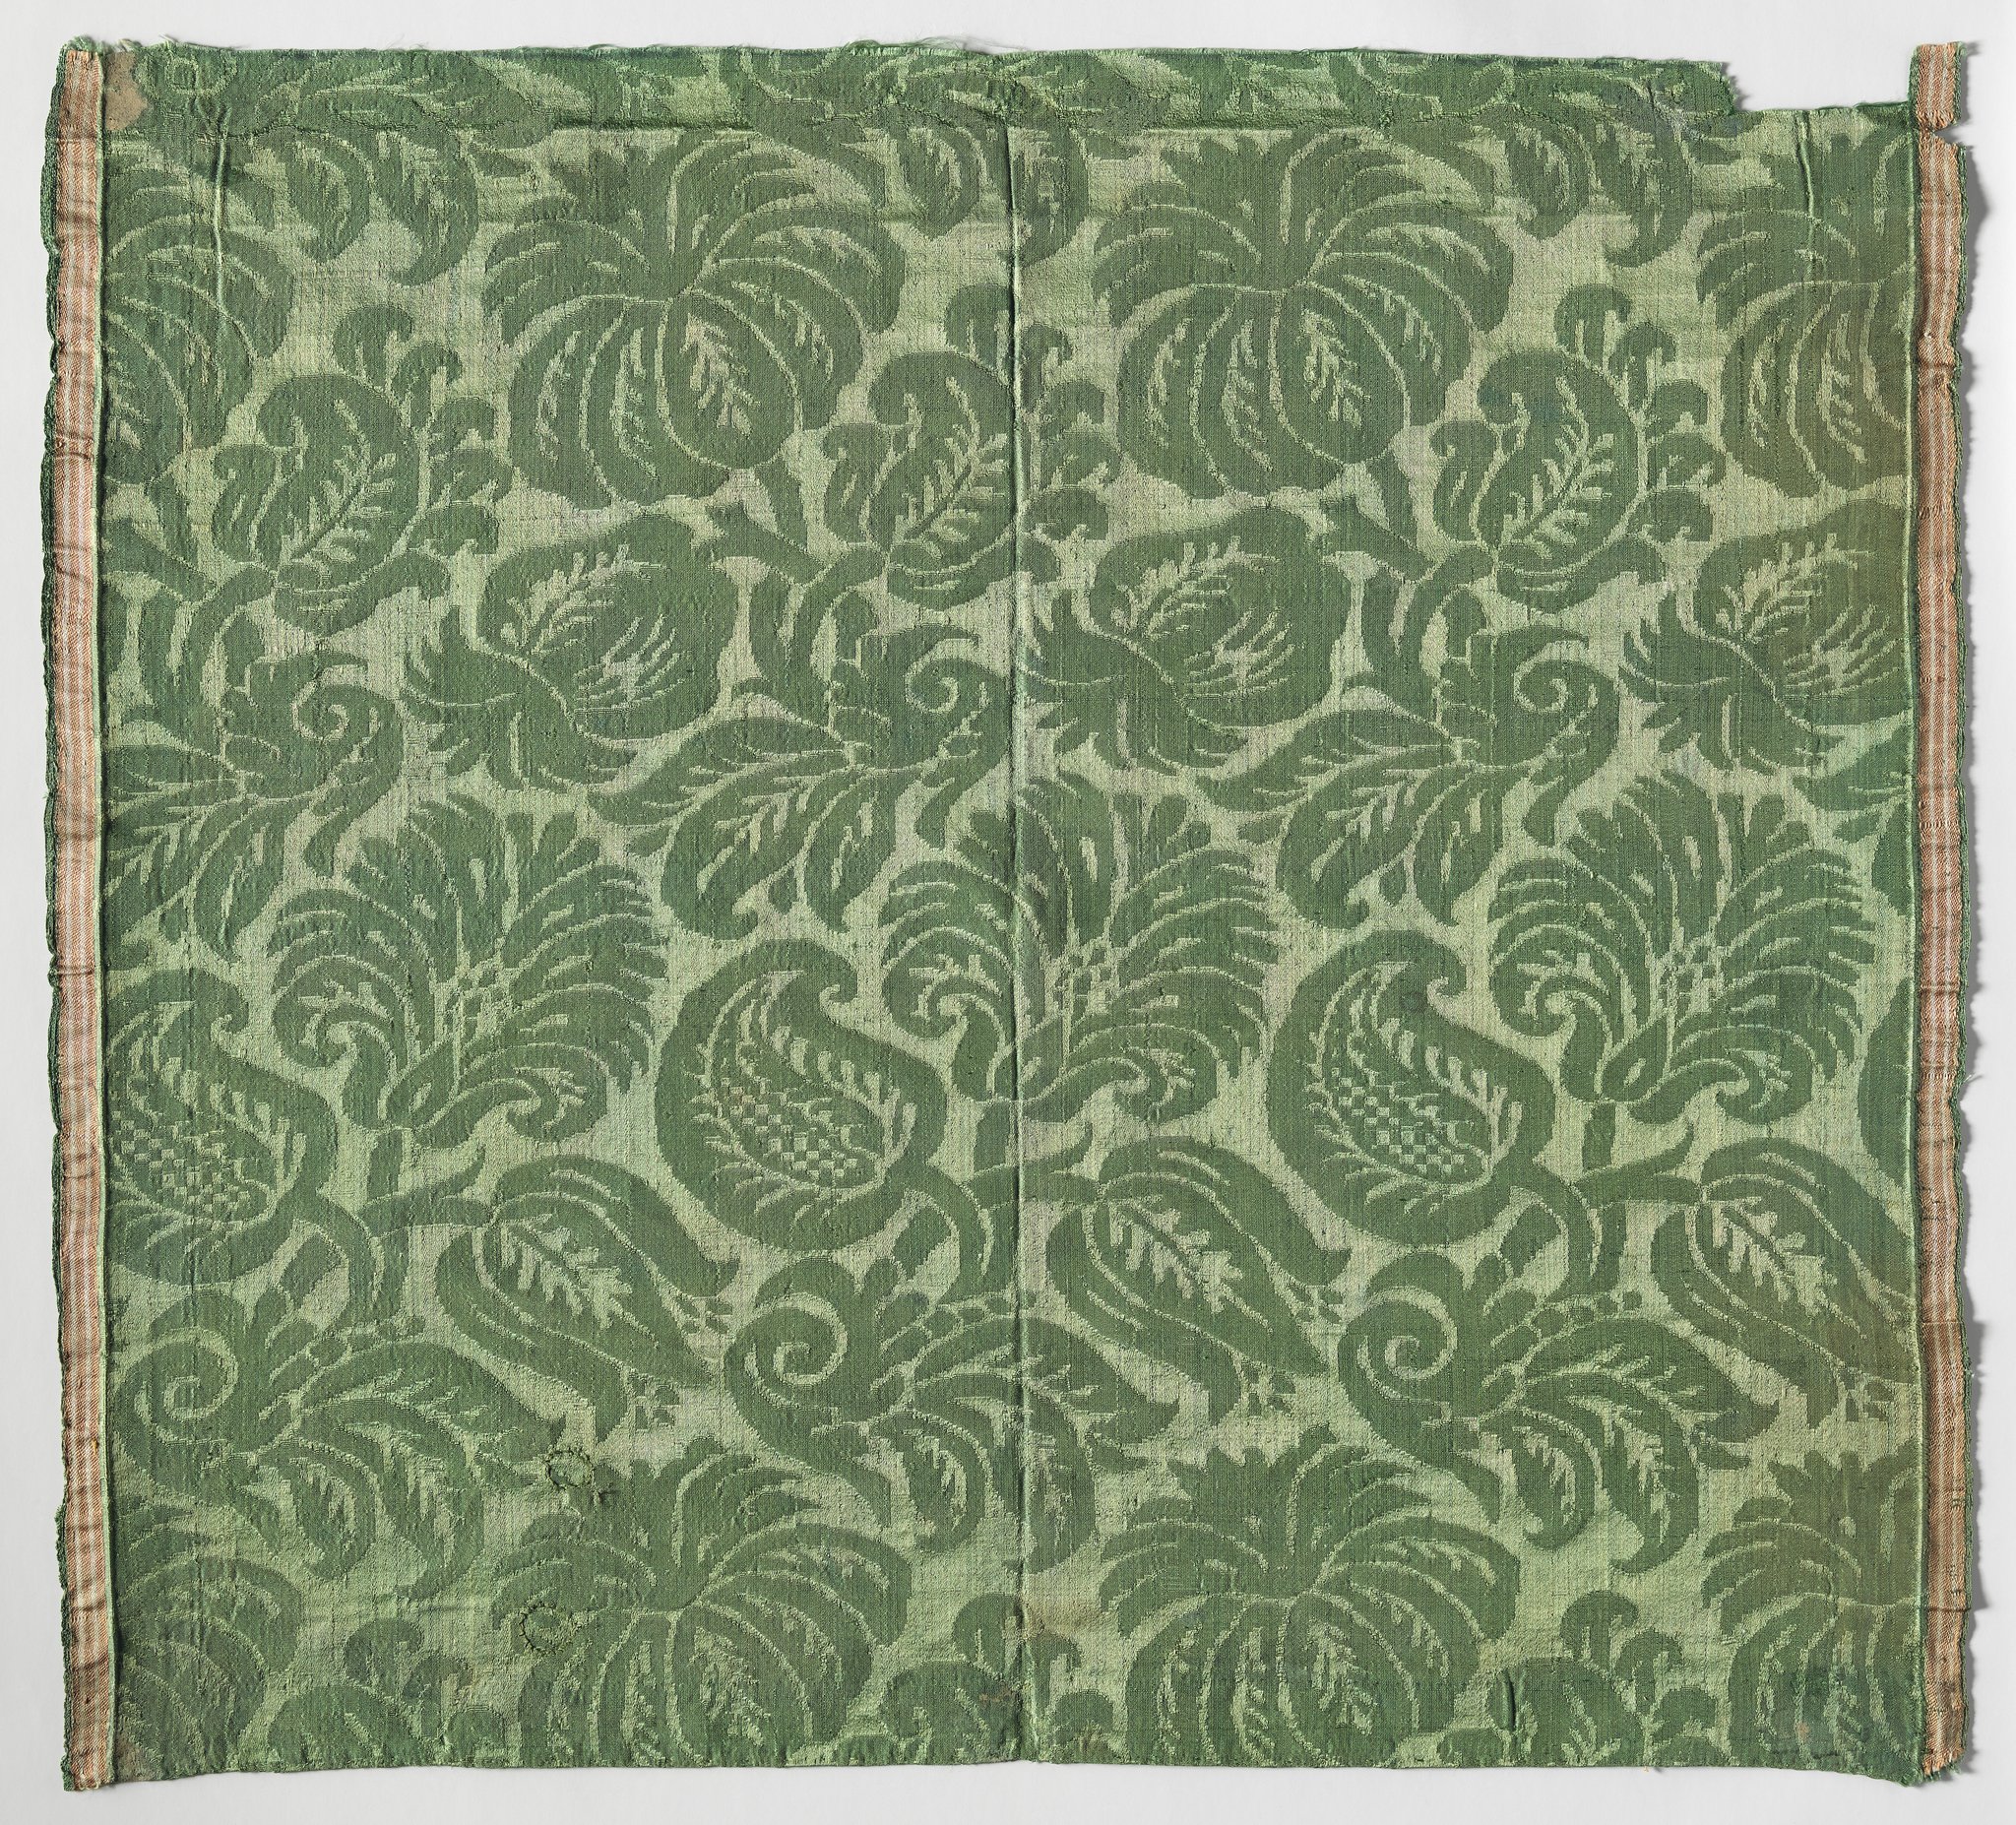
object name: piece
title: Green Silk Damask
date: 1651-1700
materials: silk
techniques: damask, weave